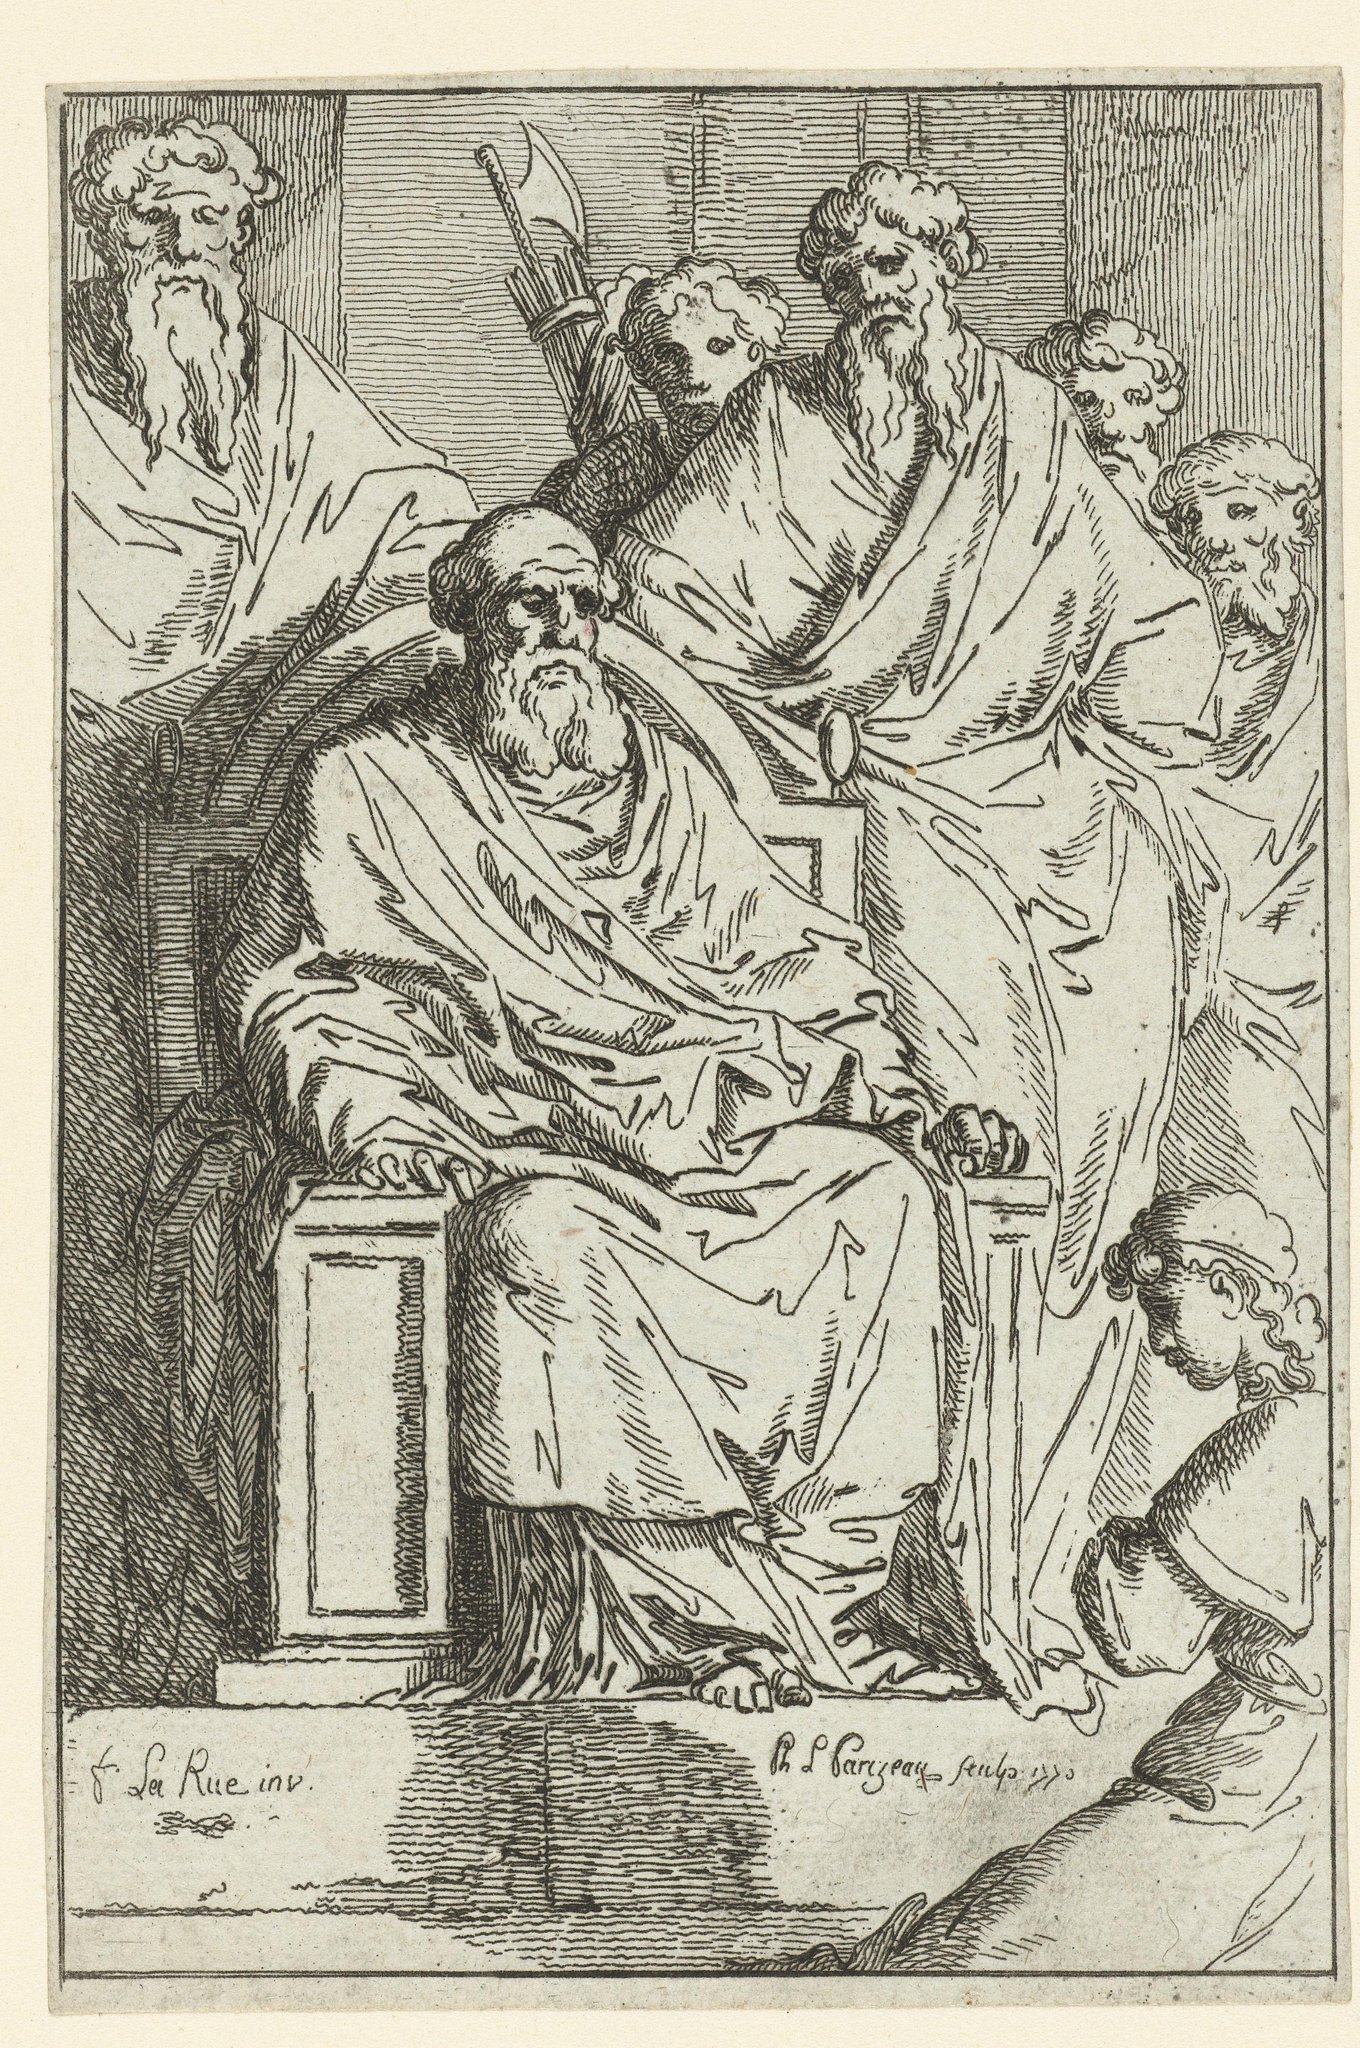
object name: print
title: Romeinse rechtspraak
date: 1770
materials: paper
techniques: etching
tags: law and jurisprudence (+ judge)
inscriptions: collector's mark: Lugt 2228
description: Een man in een toga zittend op een zetel, achter hem staan vijf mannen en vóór hem knielt een jonge vrouw.